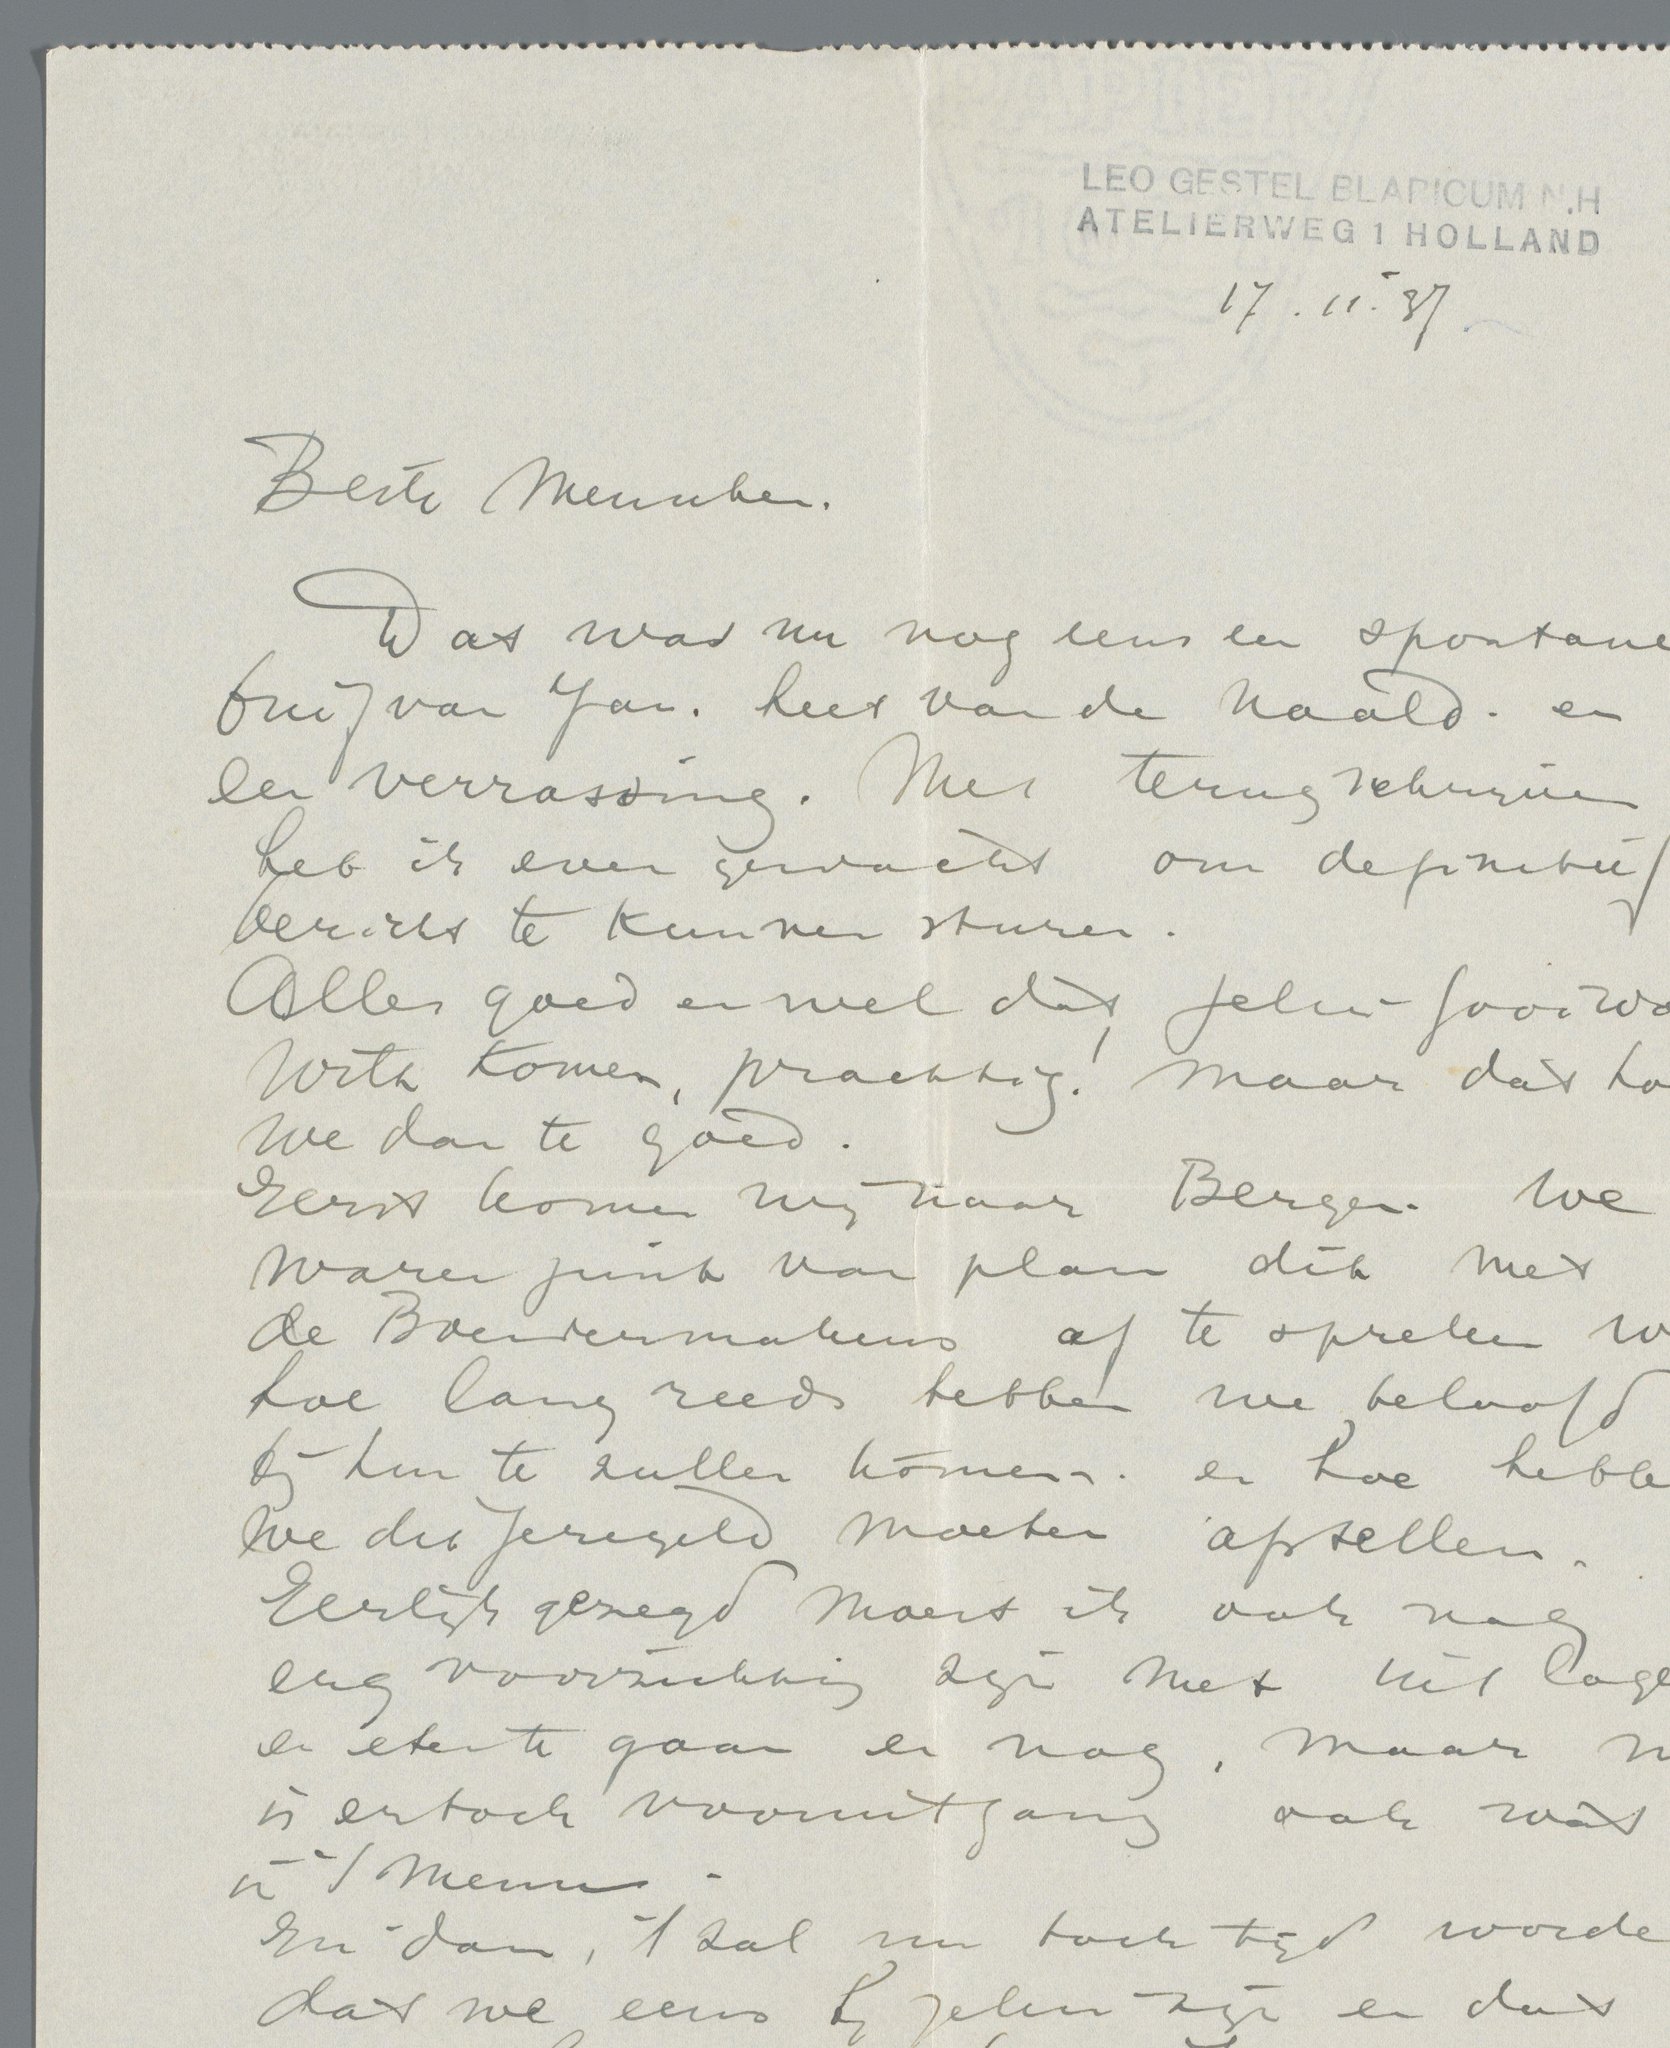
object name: letter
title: Brief aan Jan Ponstijn en Henriëtte Johanna Petronella van Hilten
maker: leo gestel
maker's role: draughtsman, print maker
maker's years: 1881-1941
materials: ink, paper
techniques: pen, writing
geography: blaricum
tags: henriëtte johanna petronella ponstijn-van hilten, johan jacob voskuil, amsterdam, print maker, draughtsman, jan petrus ponstijn, health, drawing, warfare; military affairs, paris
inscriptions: date